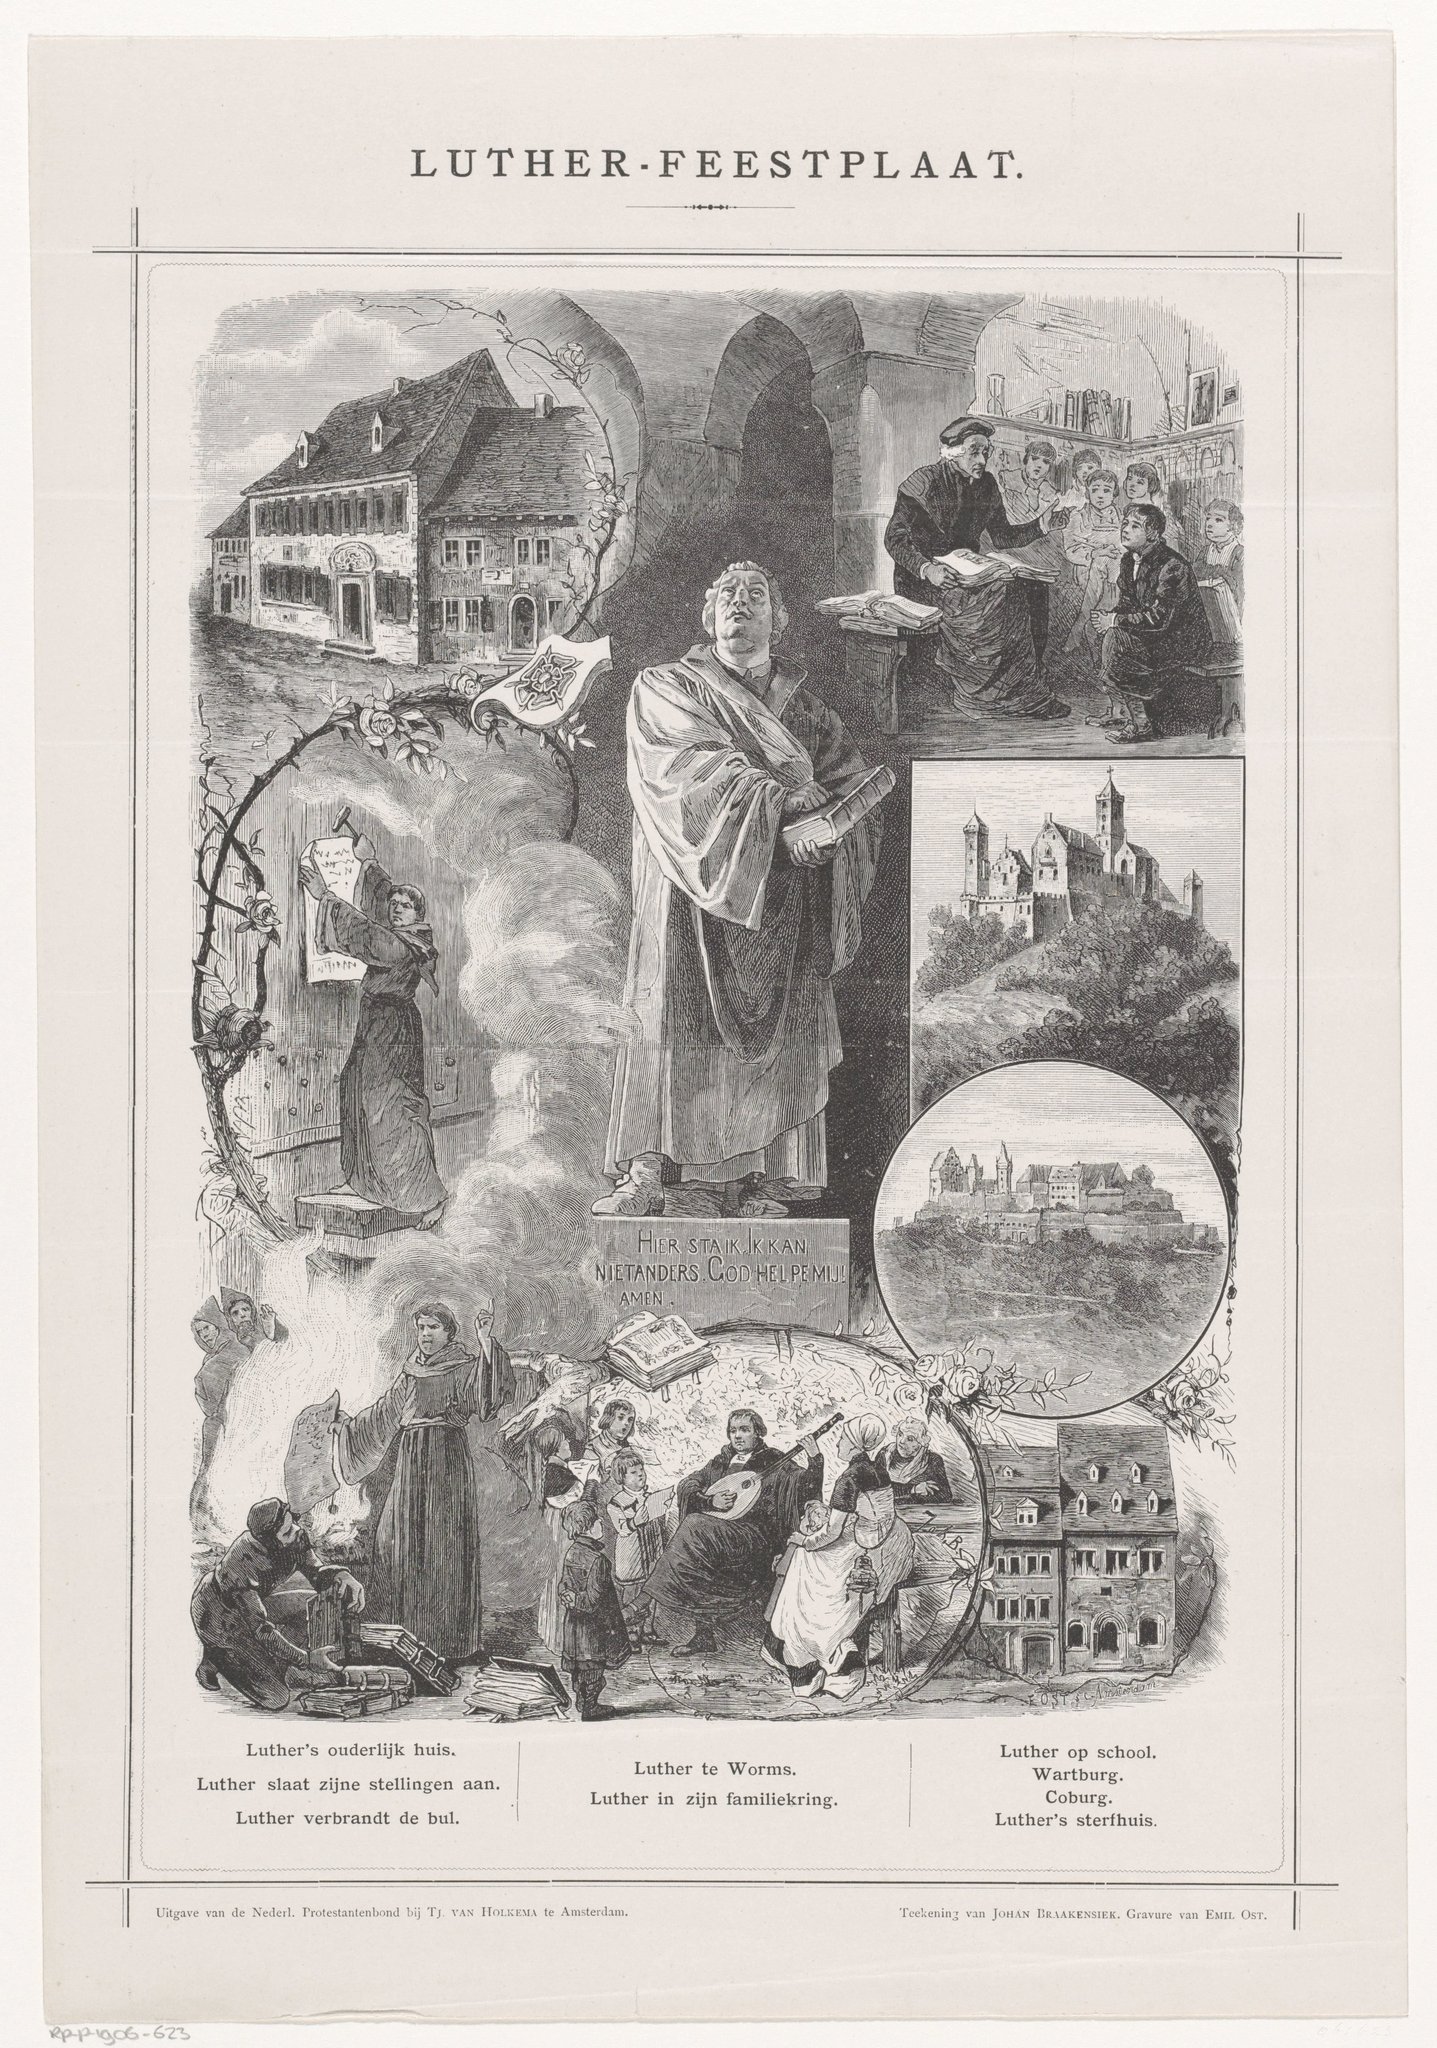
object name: print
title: Luther-feestplaat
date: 1856-1906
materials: paper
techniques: engraving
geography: amsterdam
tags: priest, martin luther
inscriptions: collector's mark: Lugt 2228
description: Negen voorstellingen uit het leven van Martin Luther, waaronder zijn ouderlijk huis, de publicatie van zijn stellingen, het verbranden van de pauselijke bul en zijn sterfhuis. In de ondermarge drie kolommen met negen regels Nederlandse tekst.